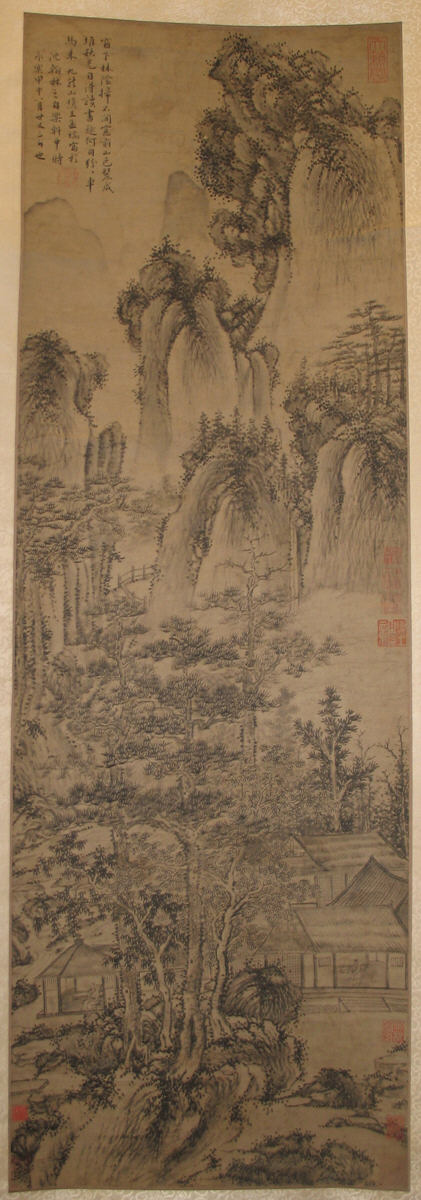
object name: hanging scroll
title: Landscape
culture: chinese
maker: unidentified artist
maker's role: artist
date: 1368-1911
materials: ink, paper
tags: mountains,landscapes